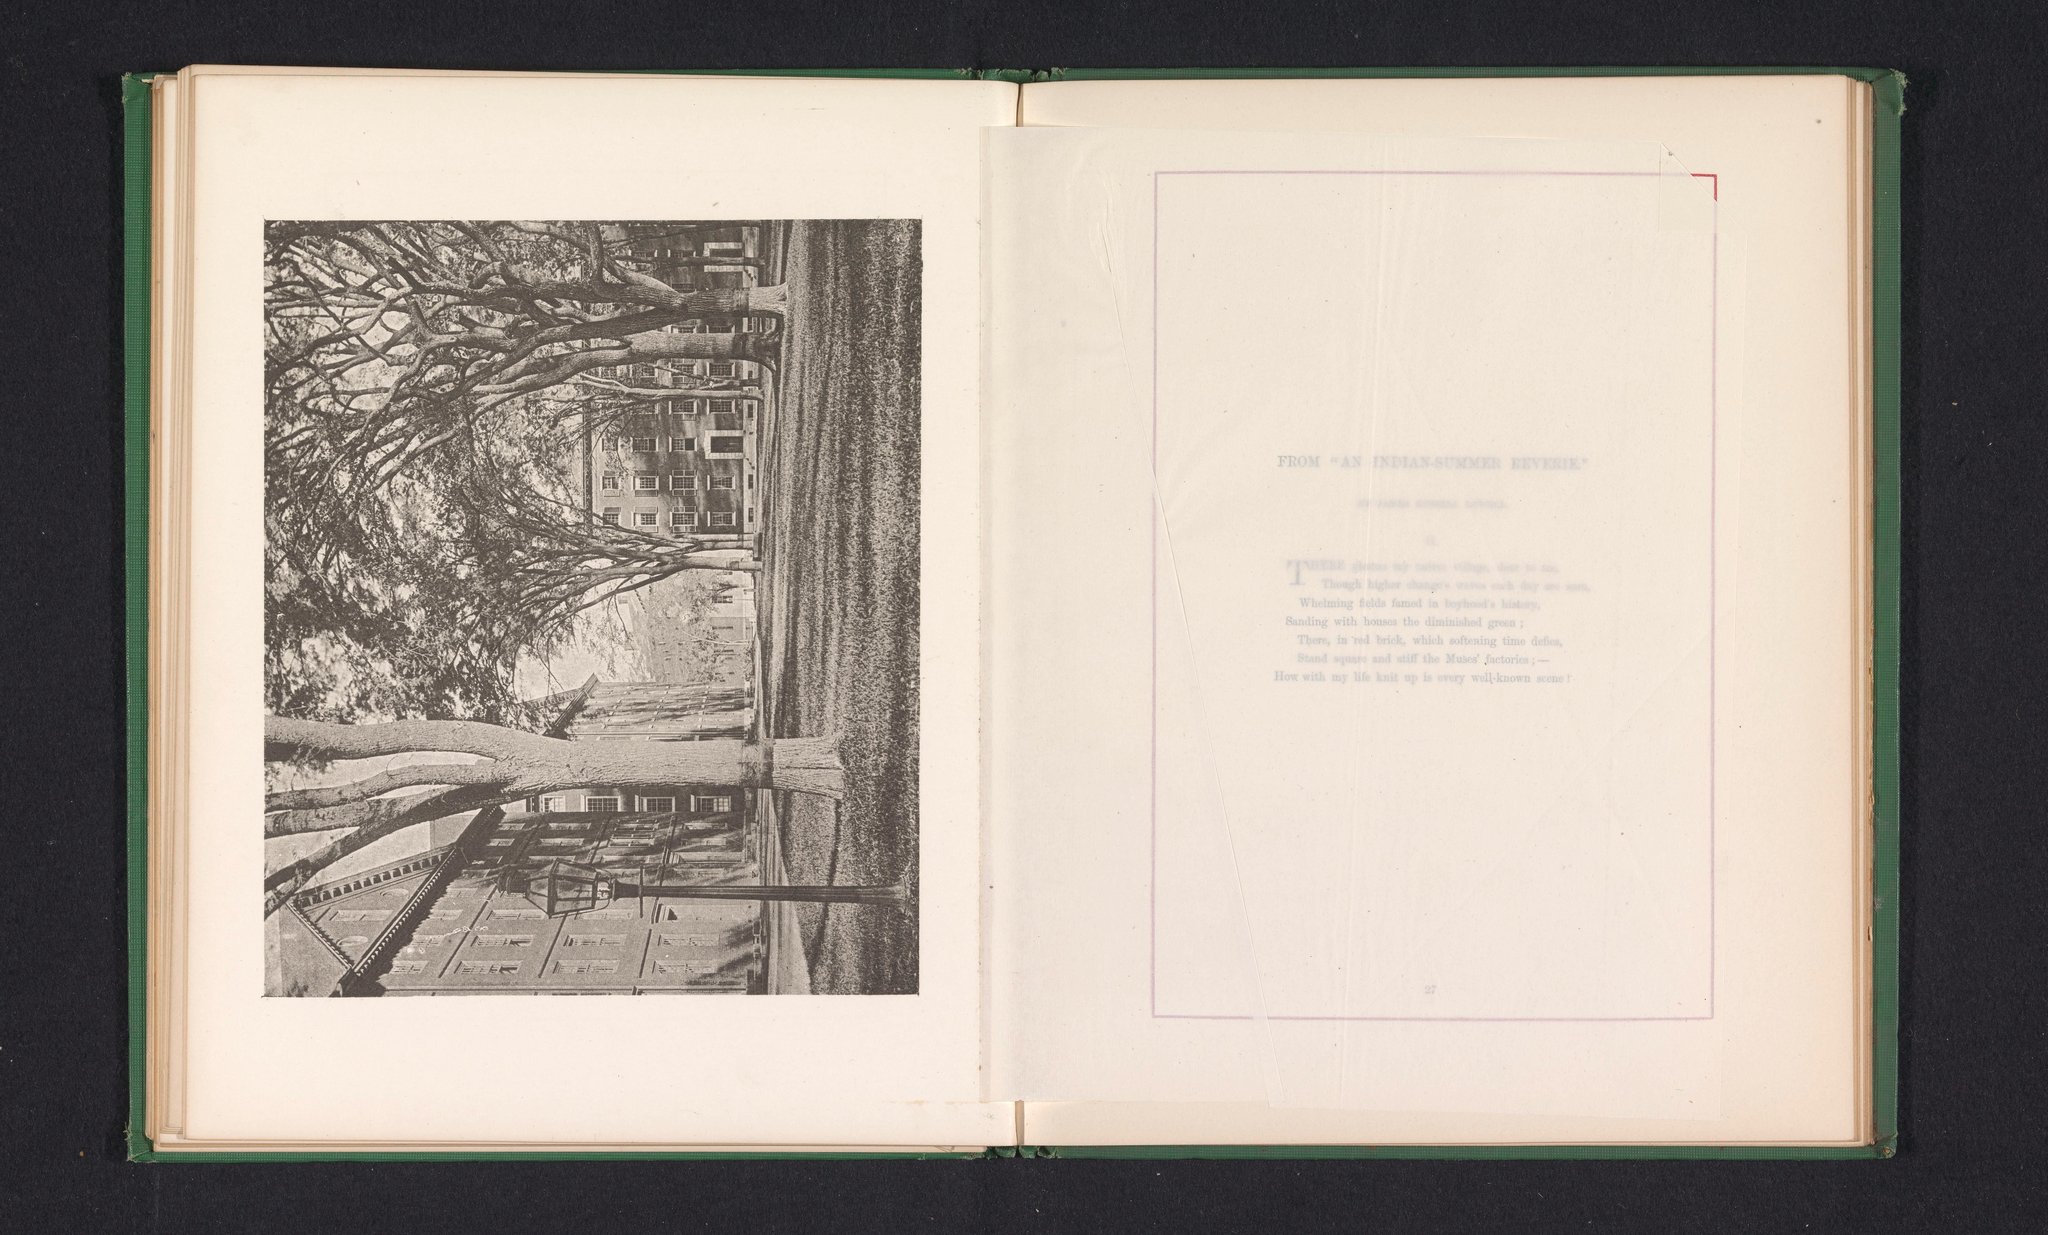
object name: page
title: Gezicht op gebouwen van Harvard College te Cambridge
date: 1866-1876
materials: paper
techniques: photograph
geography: united states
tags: university building, college, façade (of house or building)